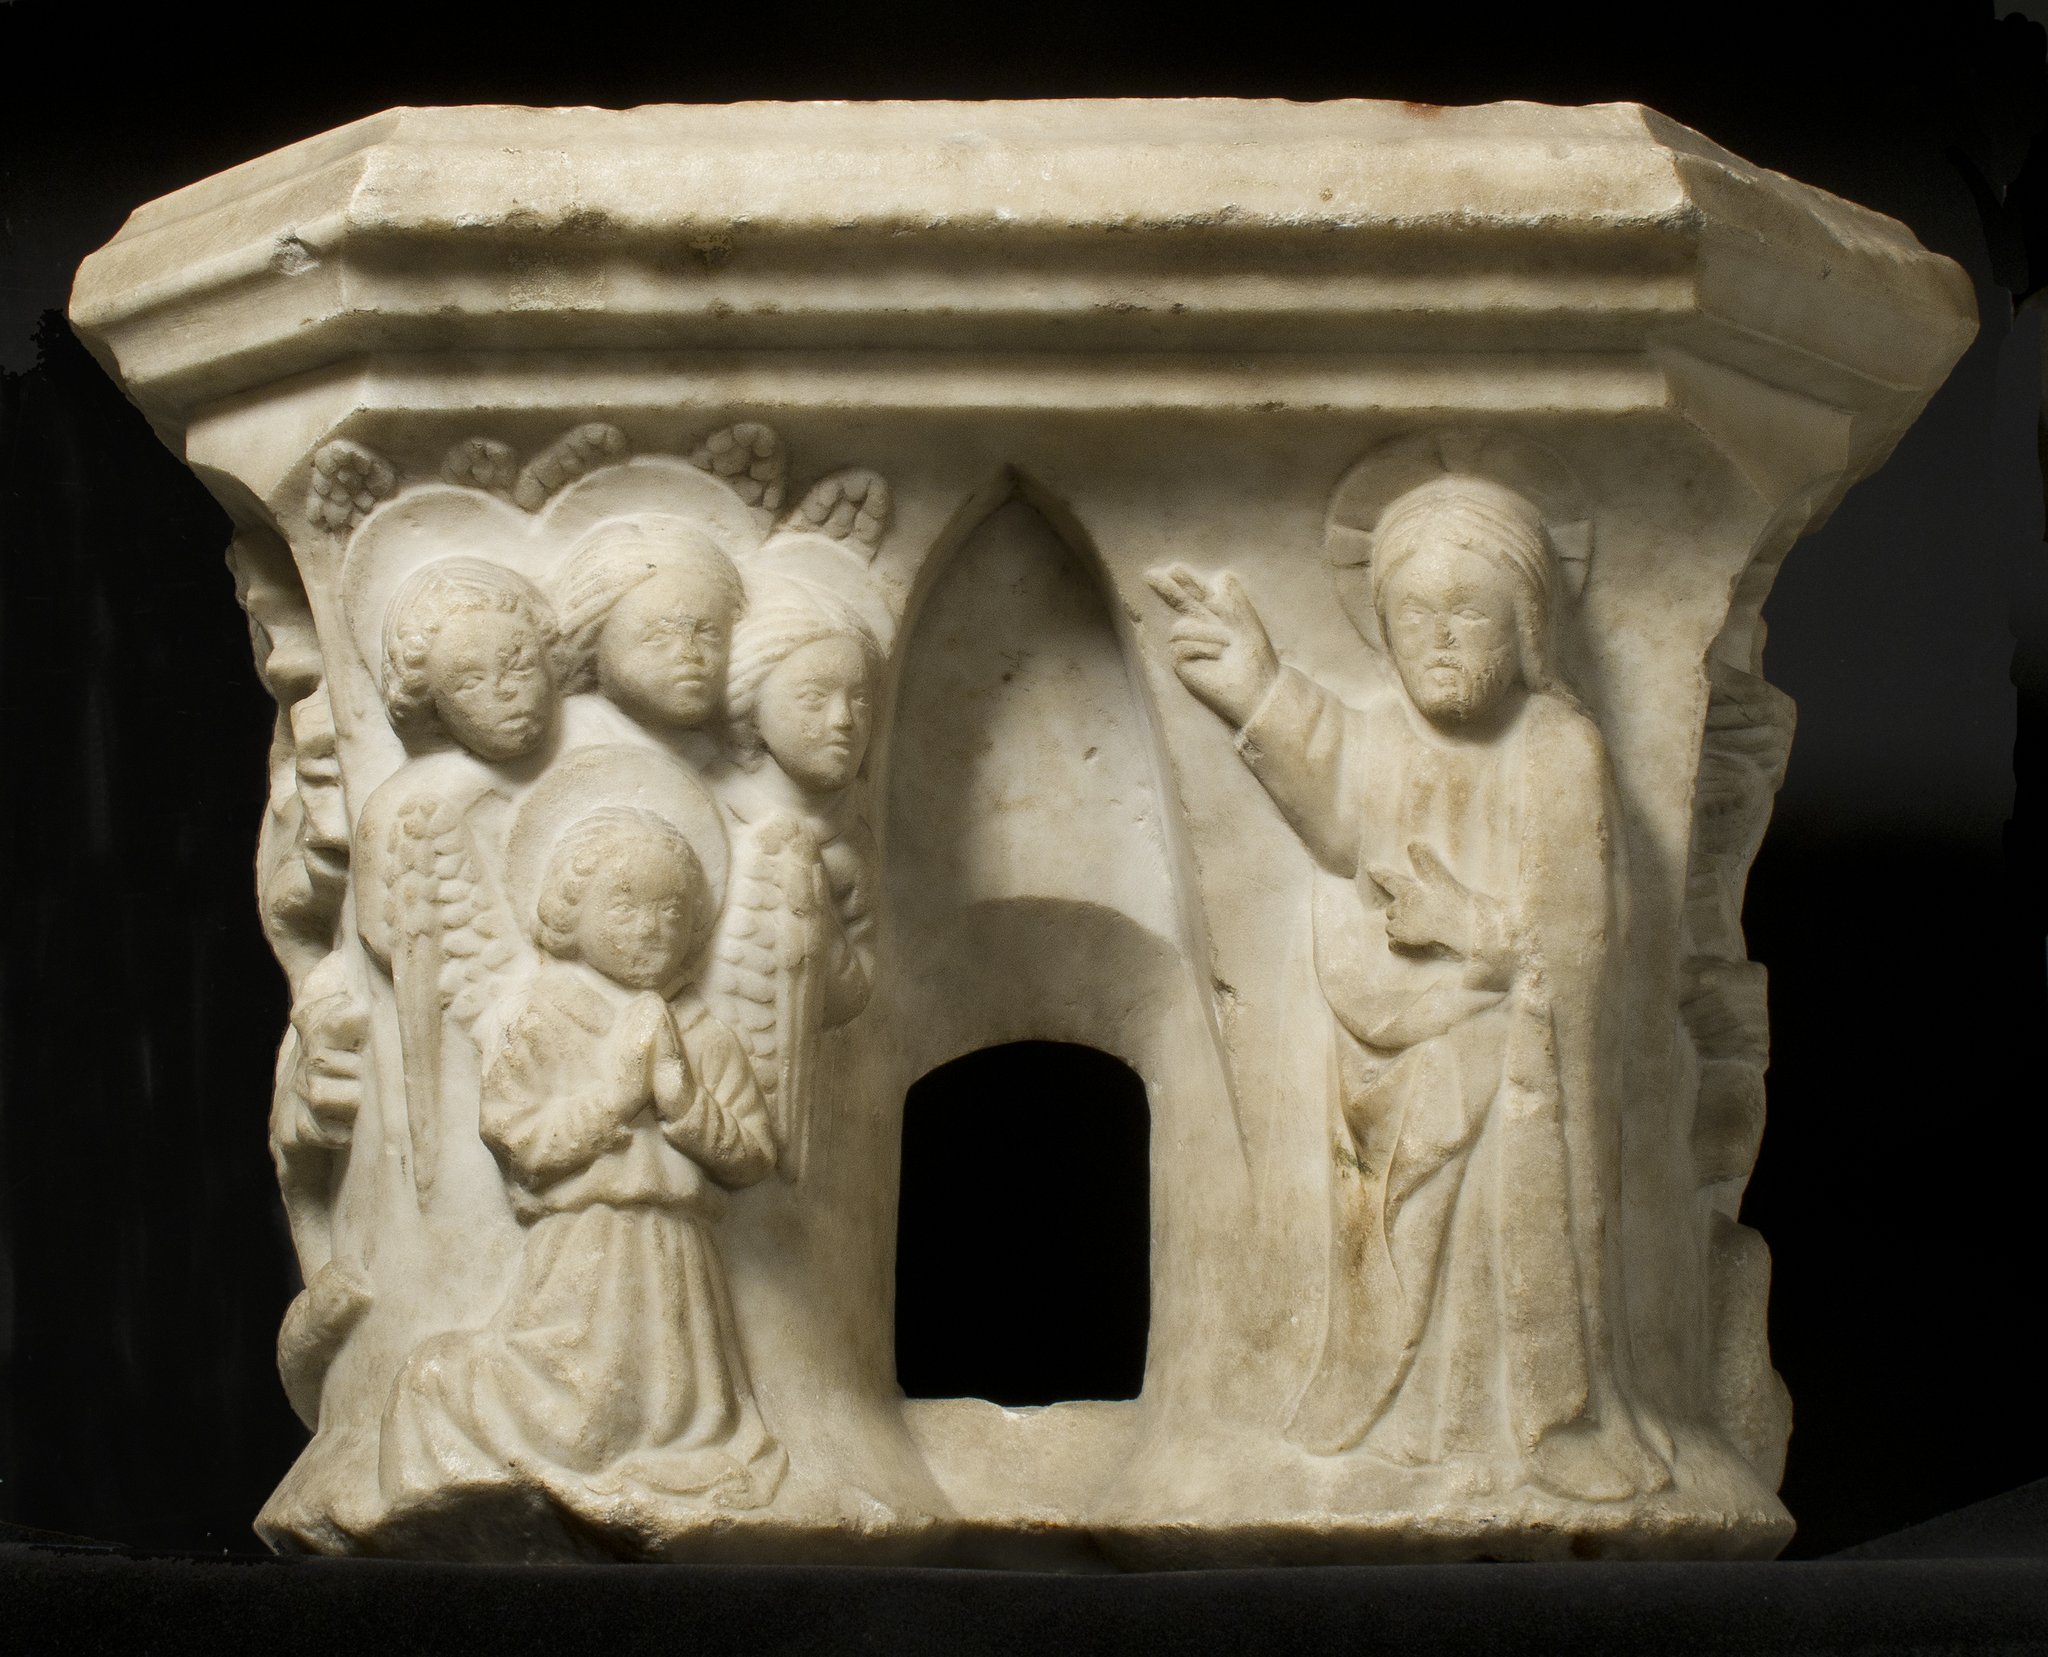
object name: capital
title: Double Capital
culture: french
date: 1467-1500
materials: marble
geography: france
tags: birds,deer,lambs,christ